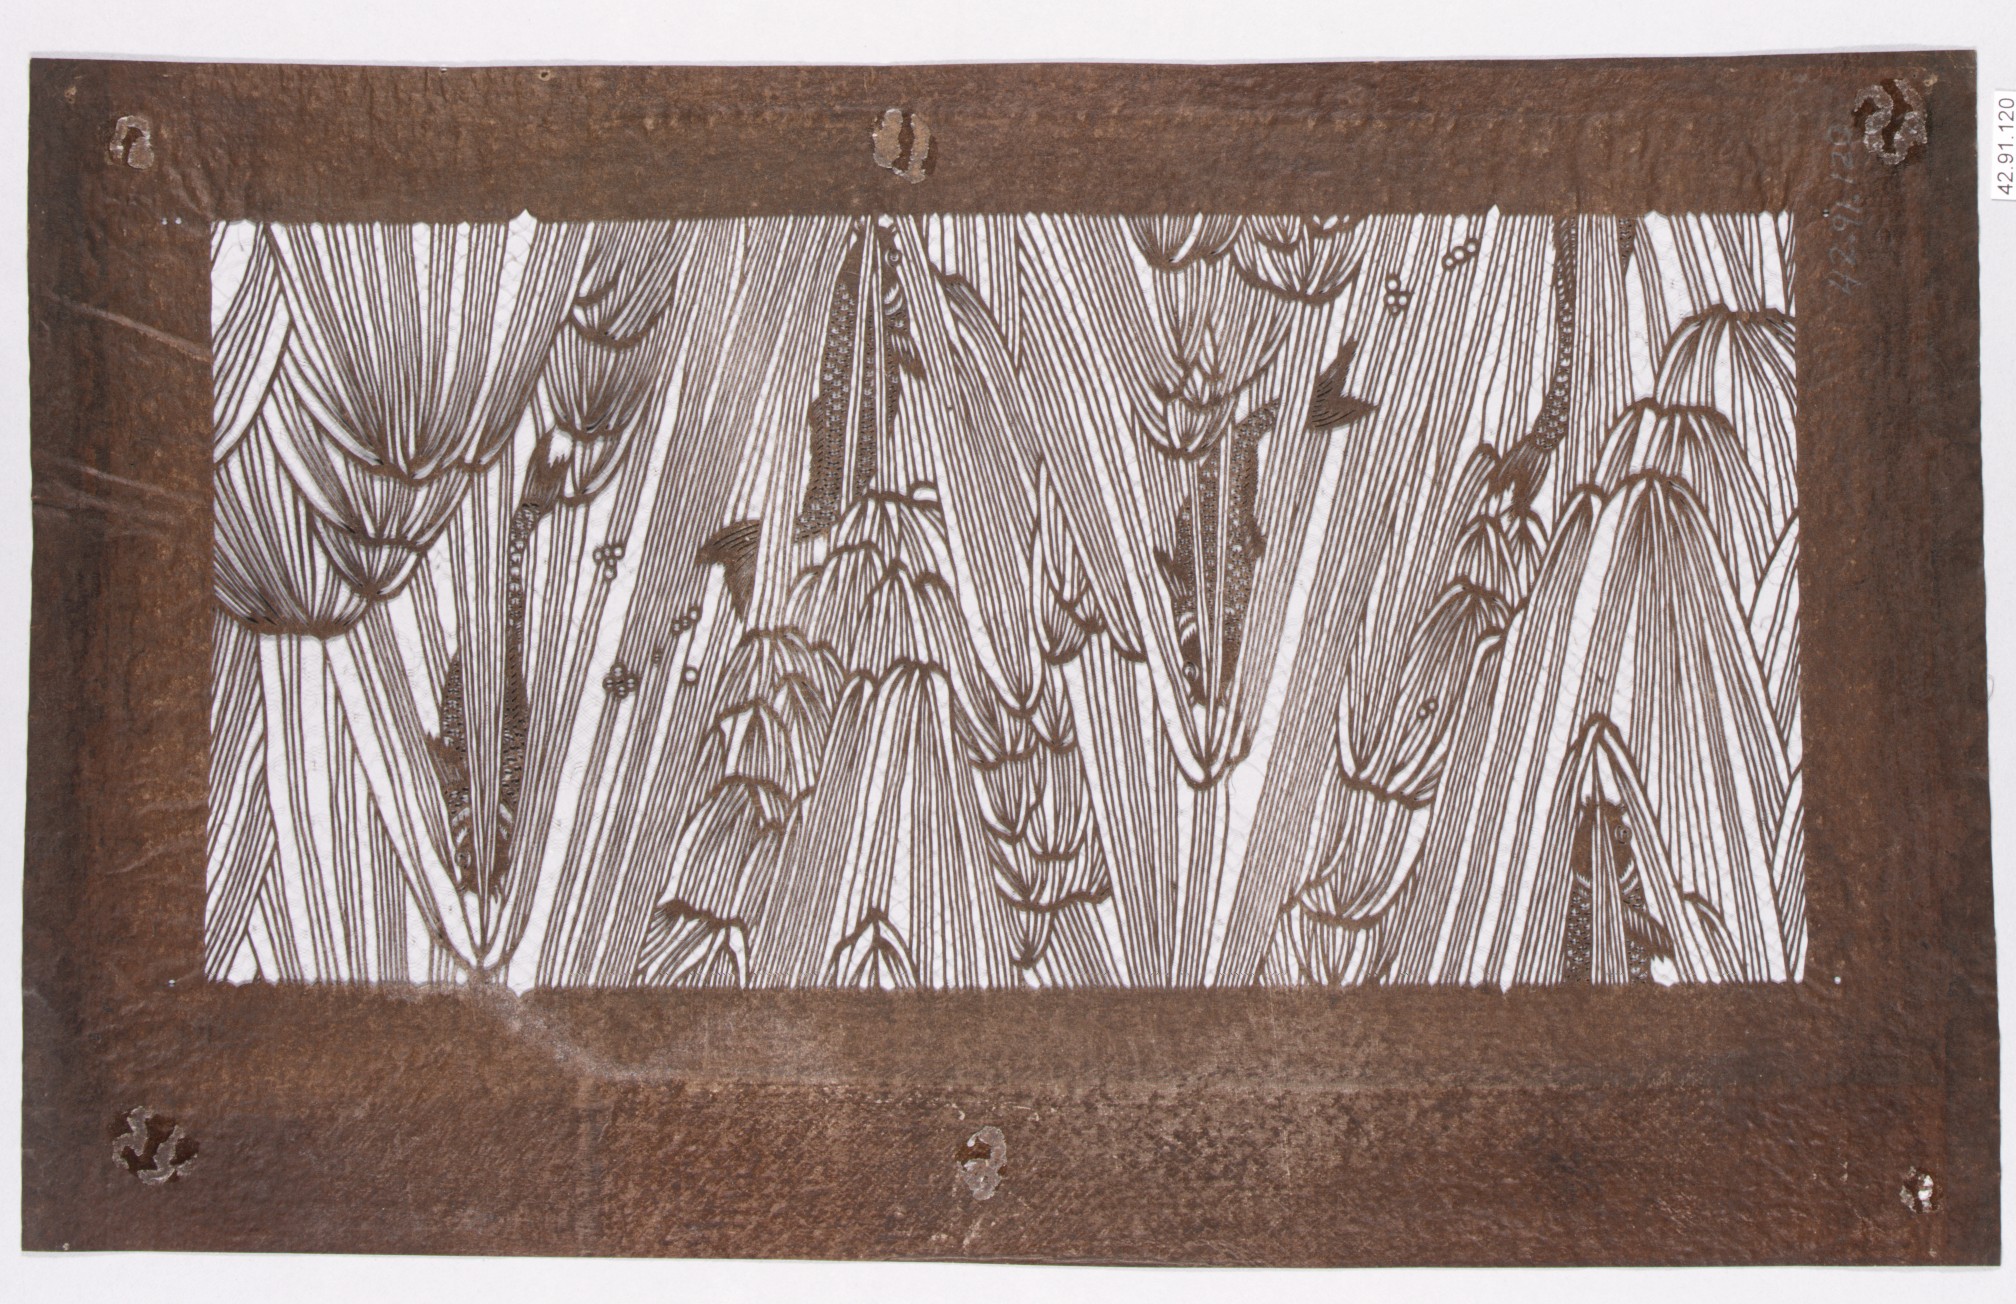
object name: stencil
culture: japanese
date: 1801-1900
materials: paper, silk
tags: fish